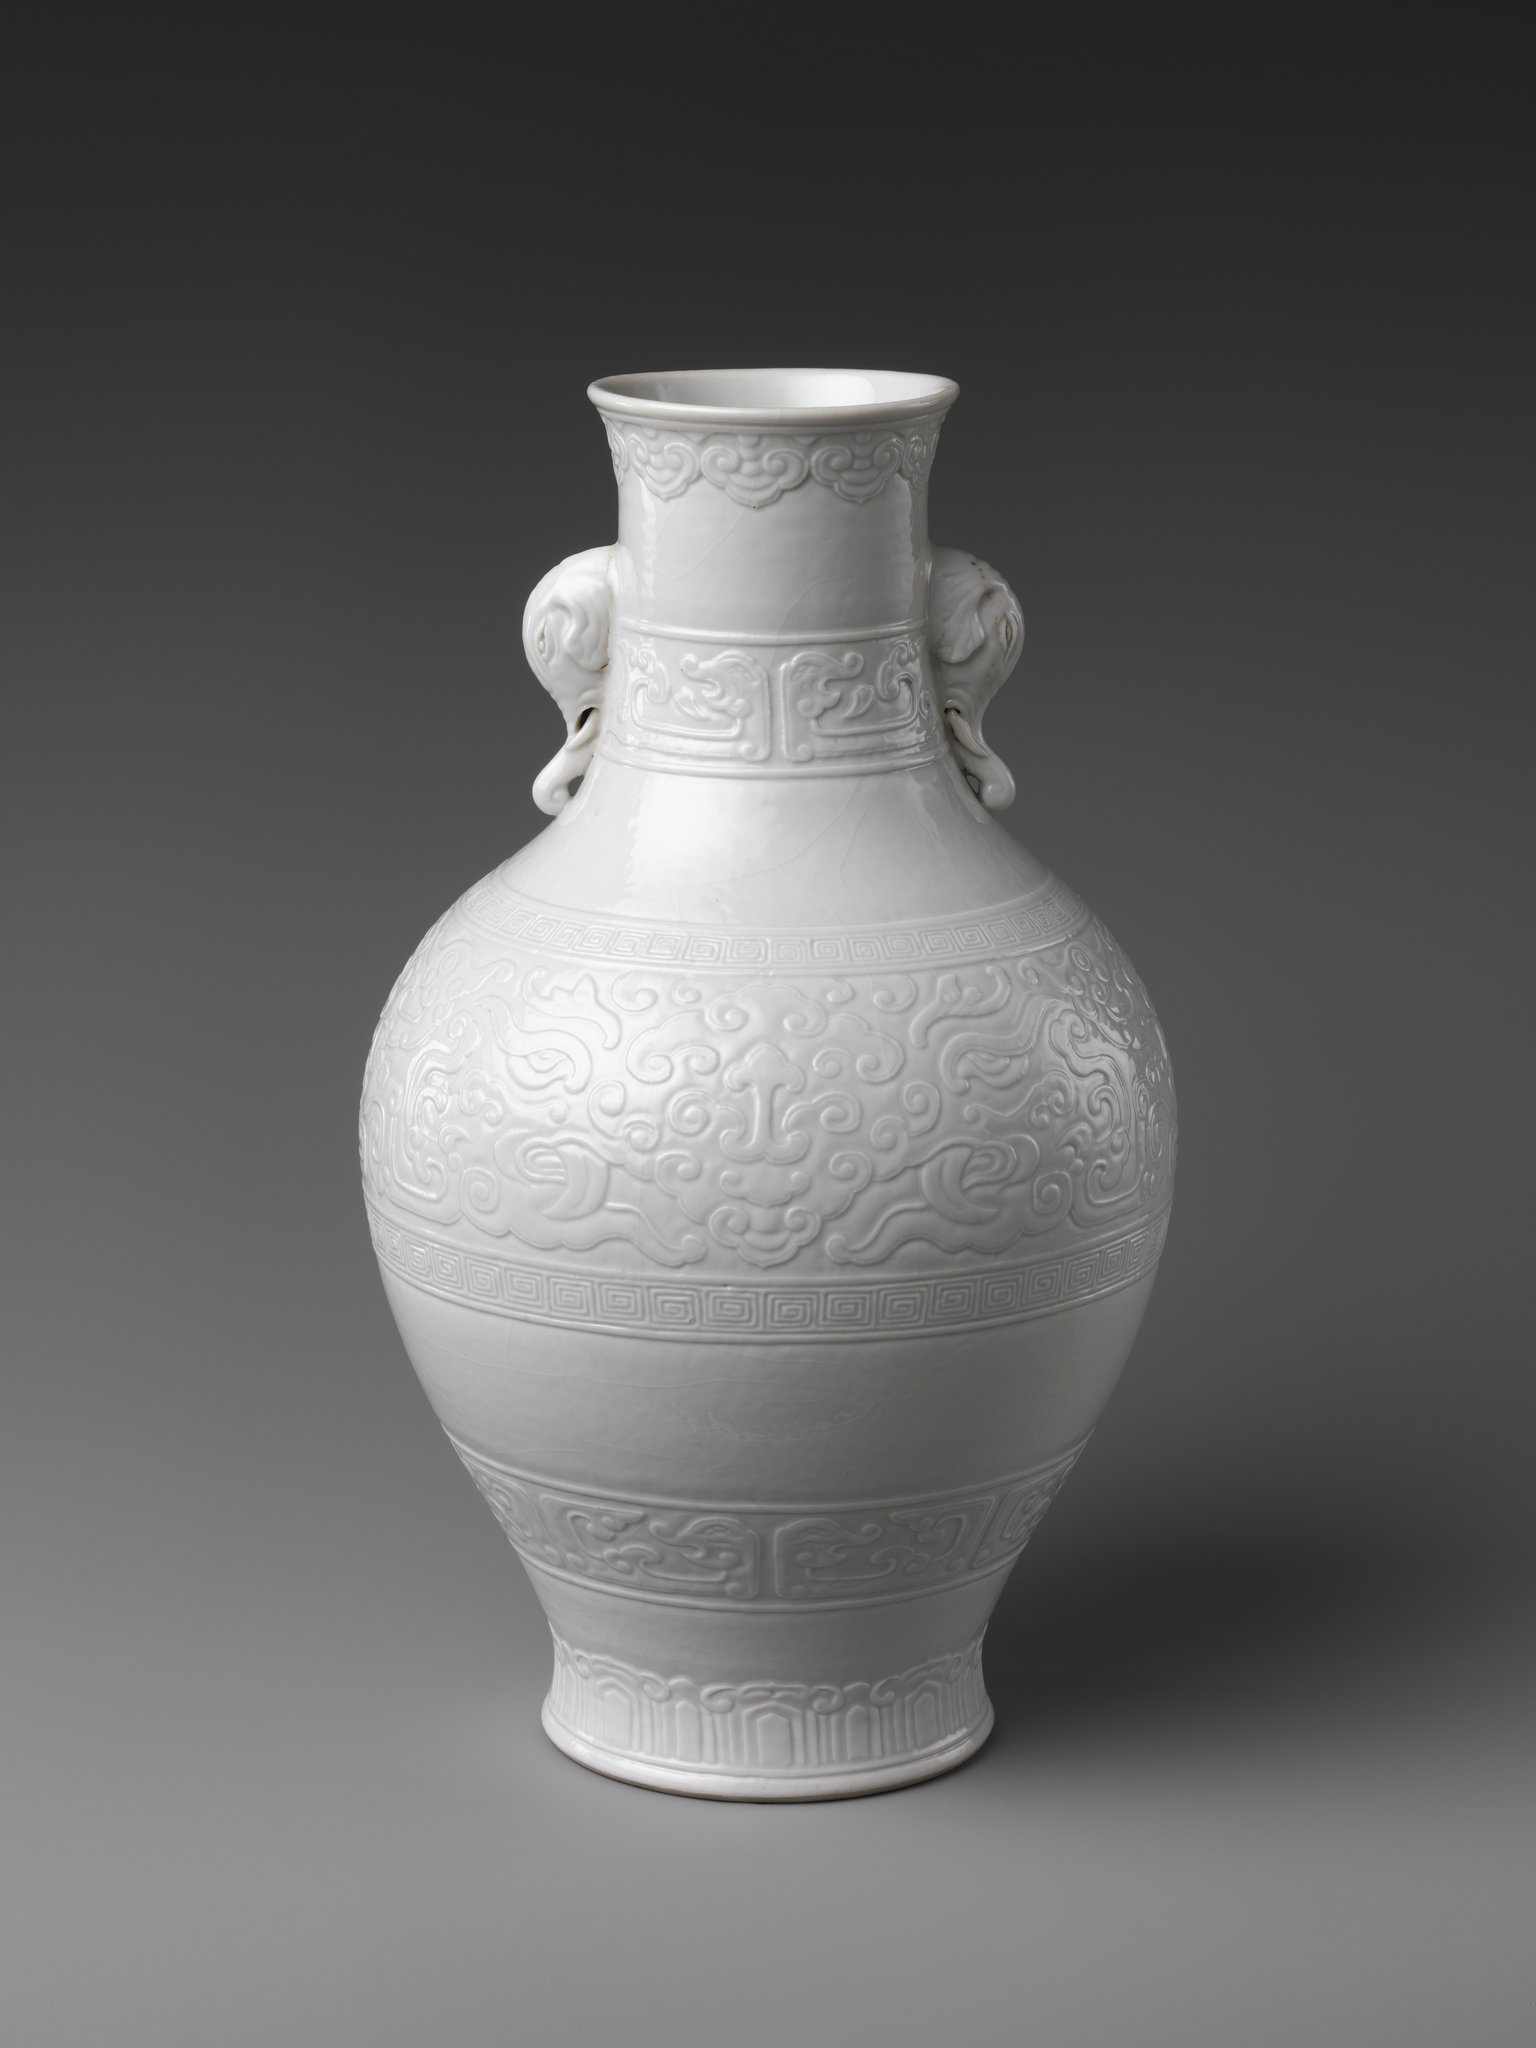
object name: vase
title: Vase with Elephant Heads and Cloud Designs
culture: chinese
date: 1736-1795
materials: soft paste porcelain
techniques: incising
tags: elephants